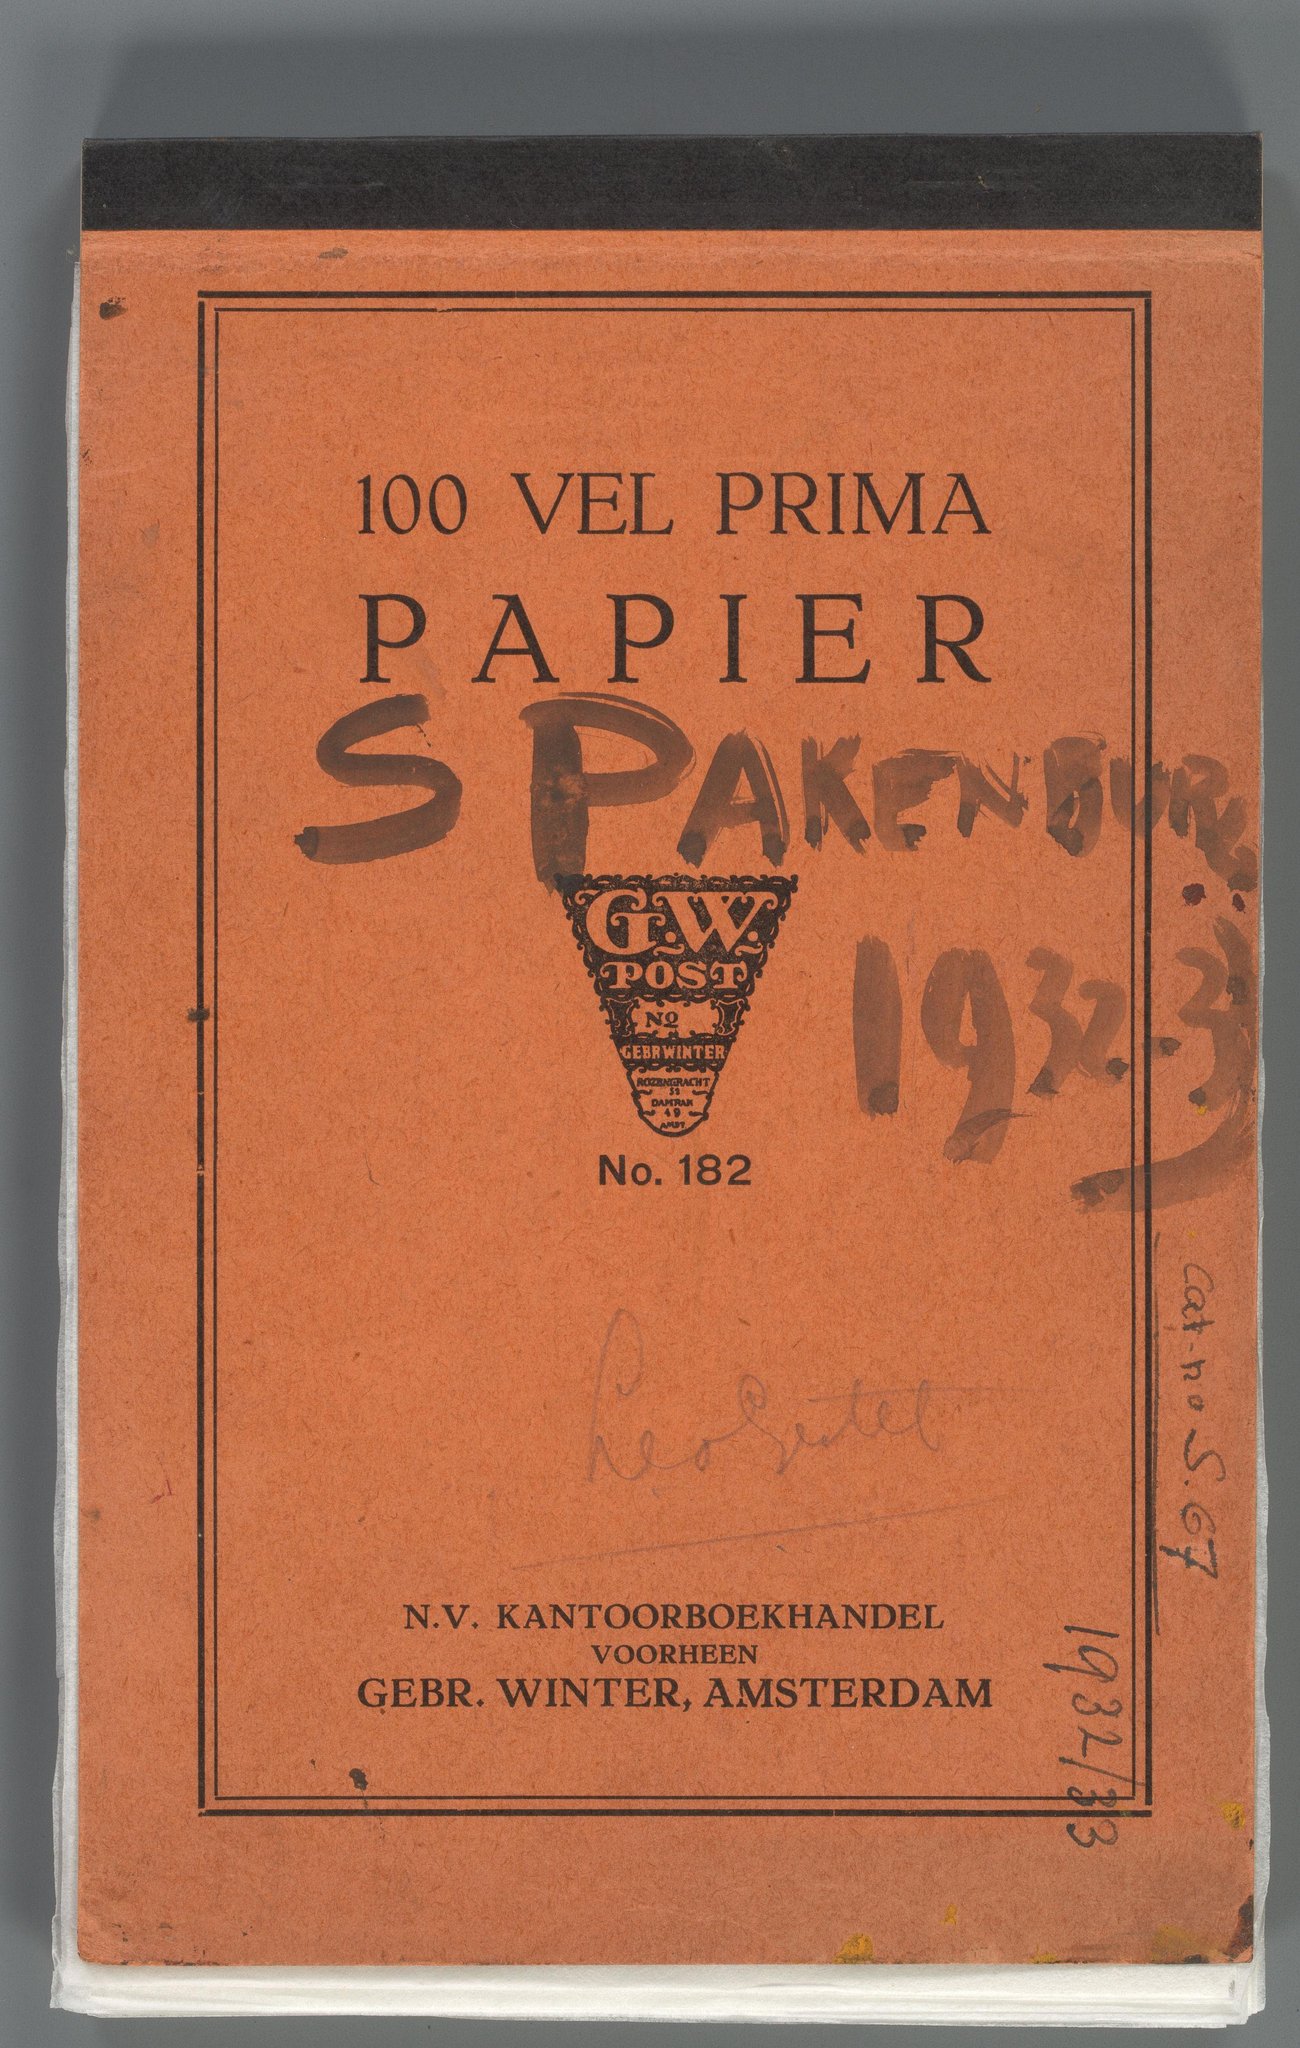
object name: sketchbook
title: Schetsboek Spakenburg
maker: leo gestel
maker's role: draughtsman, print maker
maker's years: 1881-1941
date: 1932-1933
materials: chalk, charcoal, paper, watercolor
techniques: brush, drawing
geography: spakenburg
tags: spakenburg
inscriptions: inscription: ‘schetsboek 1932-1933/ 54 bladen’, workshop stamp: Lugt 1078a, signature, date and inscription: ‘Spakenburg 1932-33/ Leo Gestel’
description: Schetsboek met schetsen van expessieve mannenkoppen, vrouwen en een meisje met pop.